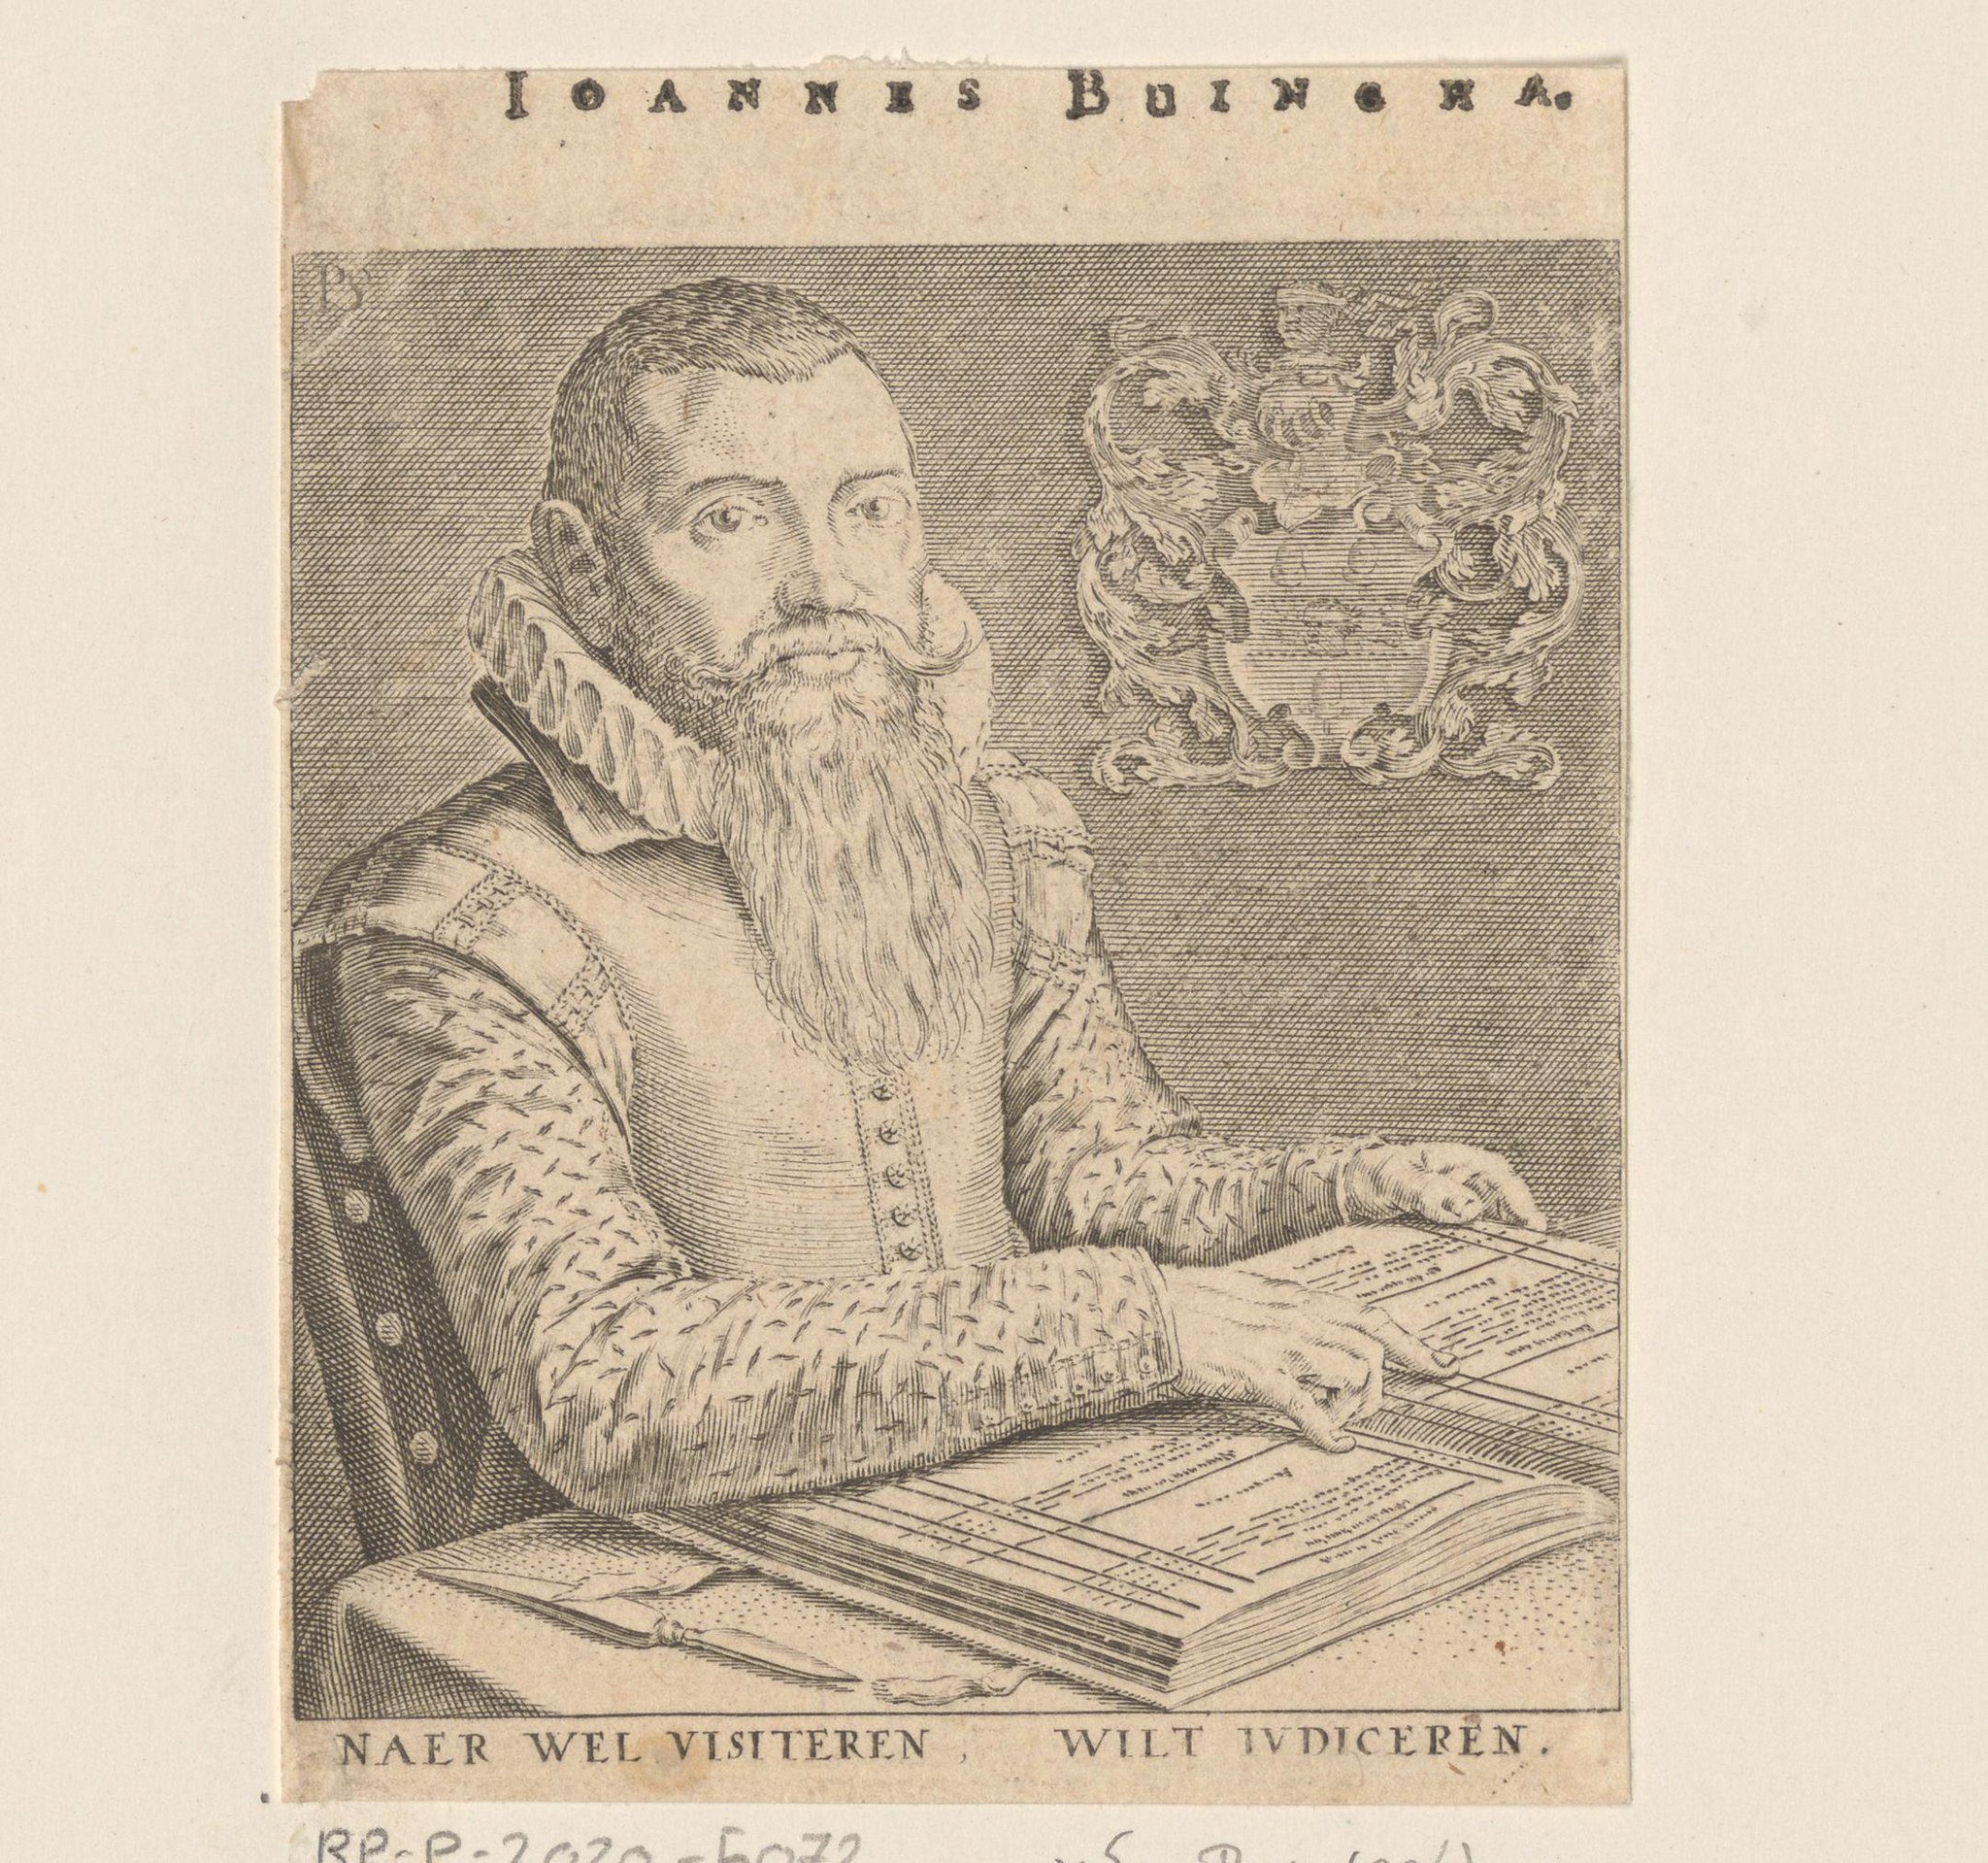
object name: book illustration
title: Portret van Joannes Buingha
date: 1629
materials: paper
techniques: engraving, letterpress printing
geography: amsterdam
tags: historical persons, book, armorial bearing, heraldry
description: Prent uit: Buingha, Joannes en Hendrick Waningen. Tresoor van't Italiaens boeck-houden. Amsterdam: Willem Jansz. Stam, 1629. Prent ook gebruikt in latere werken van dezelfde auteur.